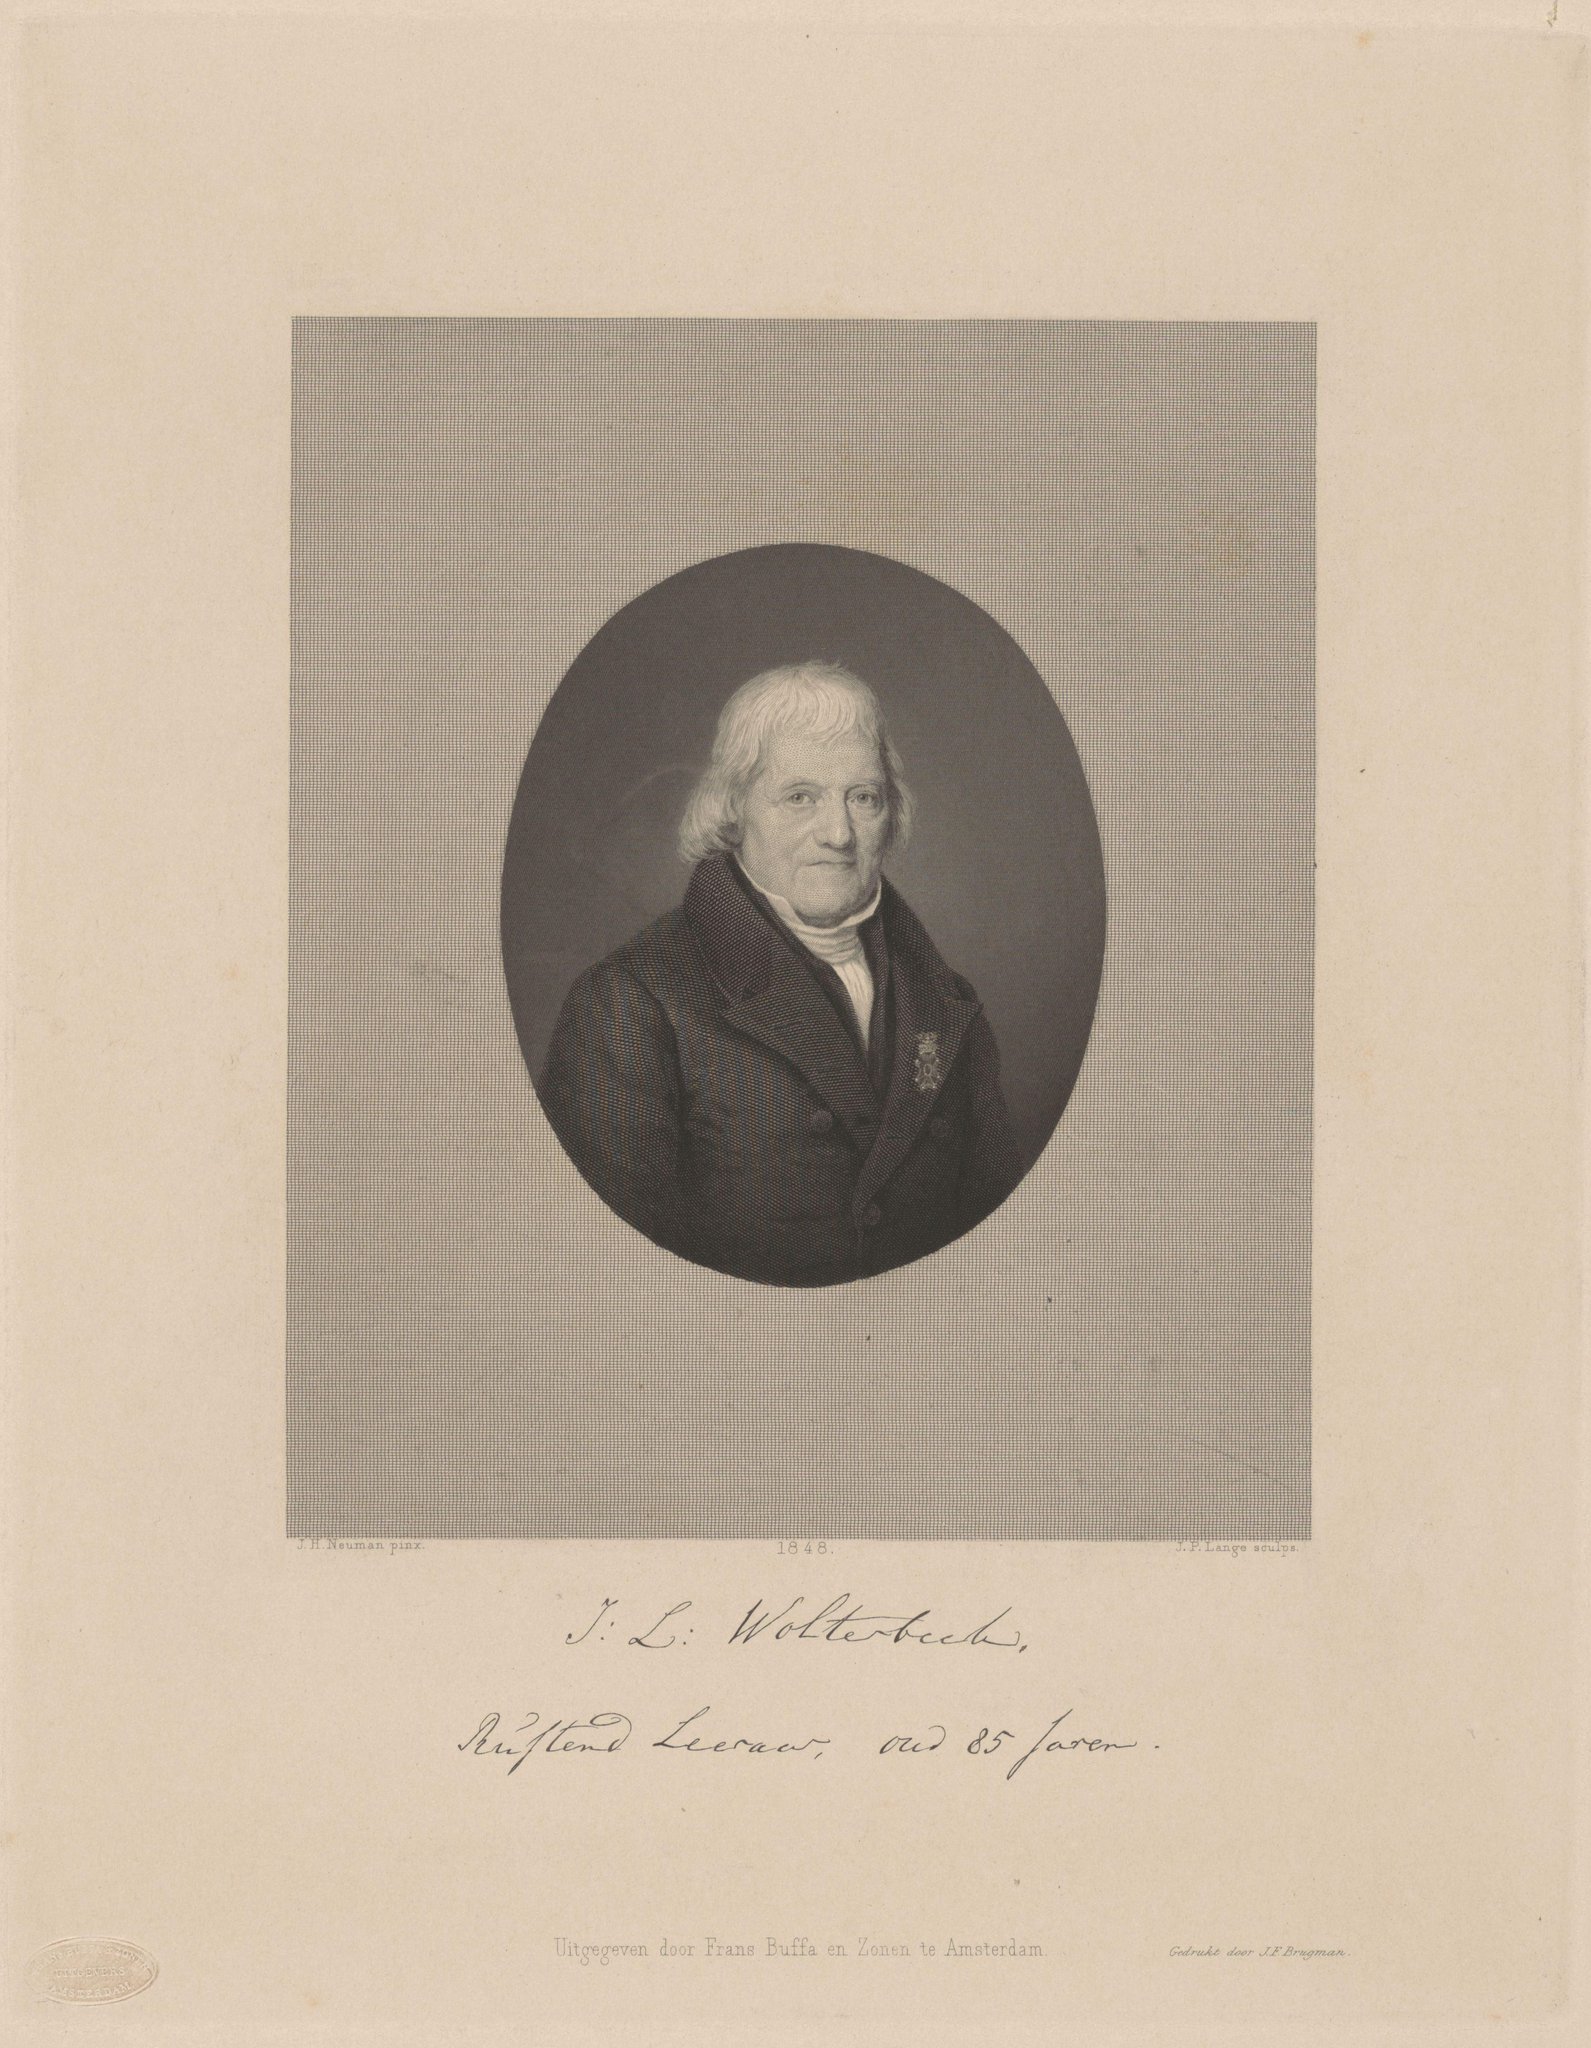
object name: print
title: Portret van Johannes Leonardus Wolterbeek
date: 1848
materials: paper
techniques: engraving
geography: netherlands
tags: functionaries and dignitaries ~ protestant churches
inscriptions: company name: ‘Frans Buffa & Zonen / Amsterdam / Uitgevers’, collector's mark: Lugt 2228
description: Portret van de predikant Johannes Leonardus Wolterbeek op 85-jarige leeftijd, buste in ovaal naar rechts.